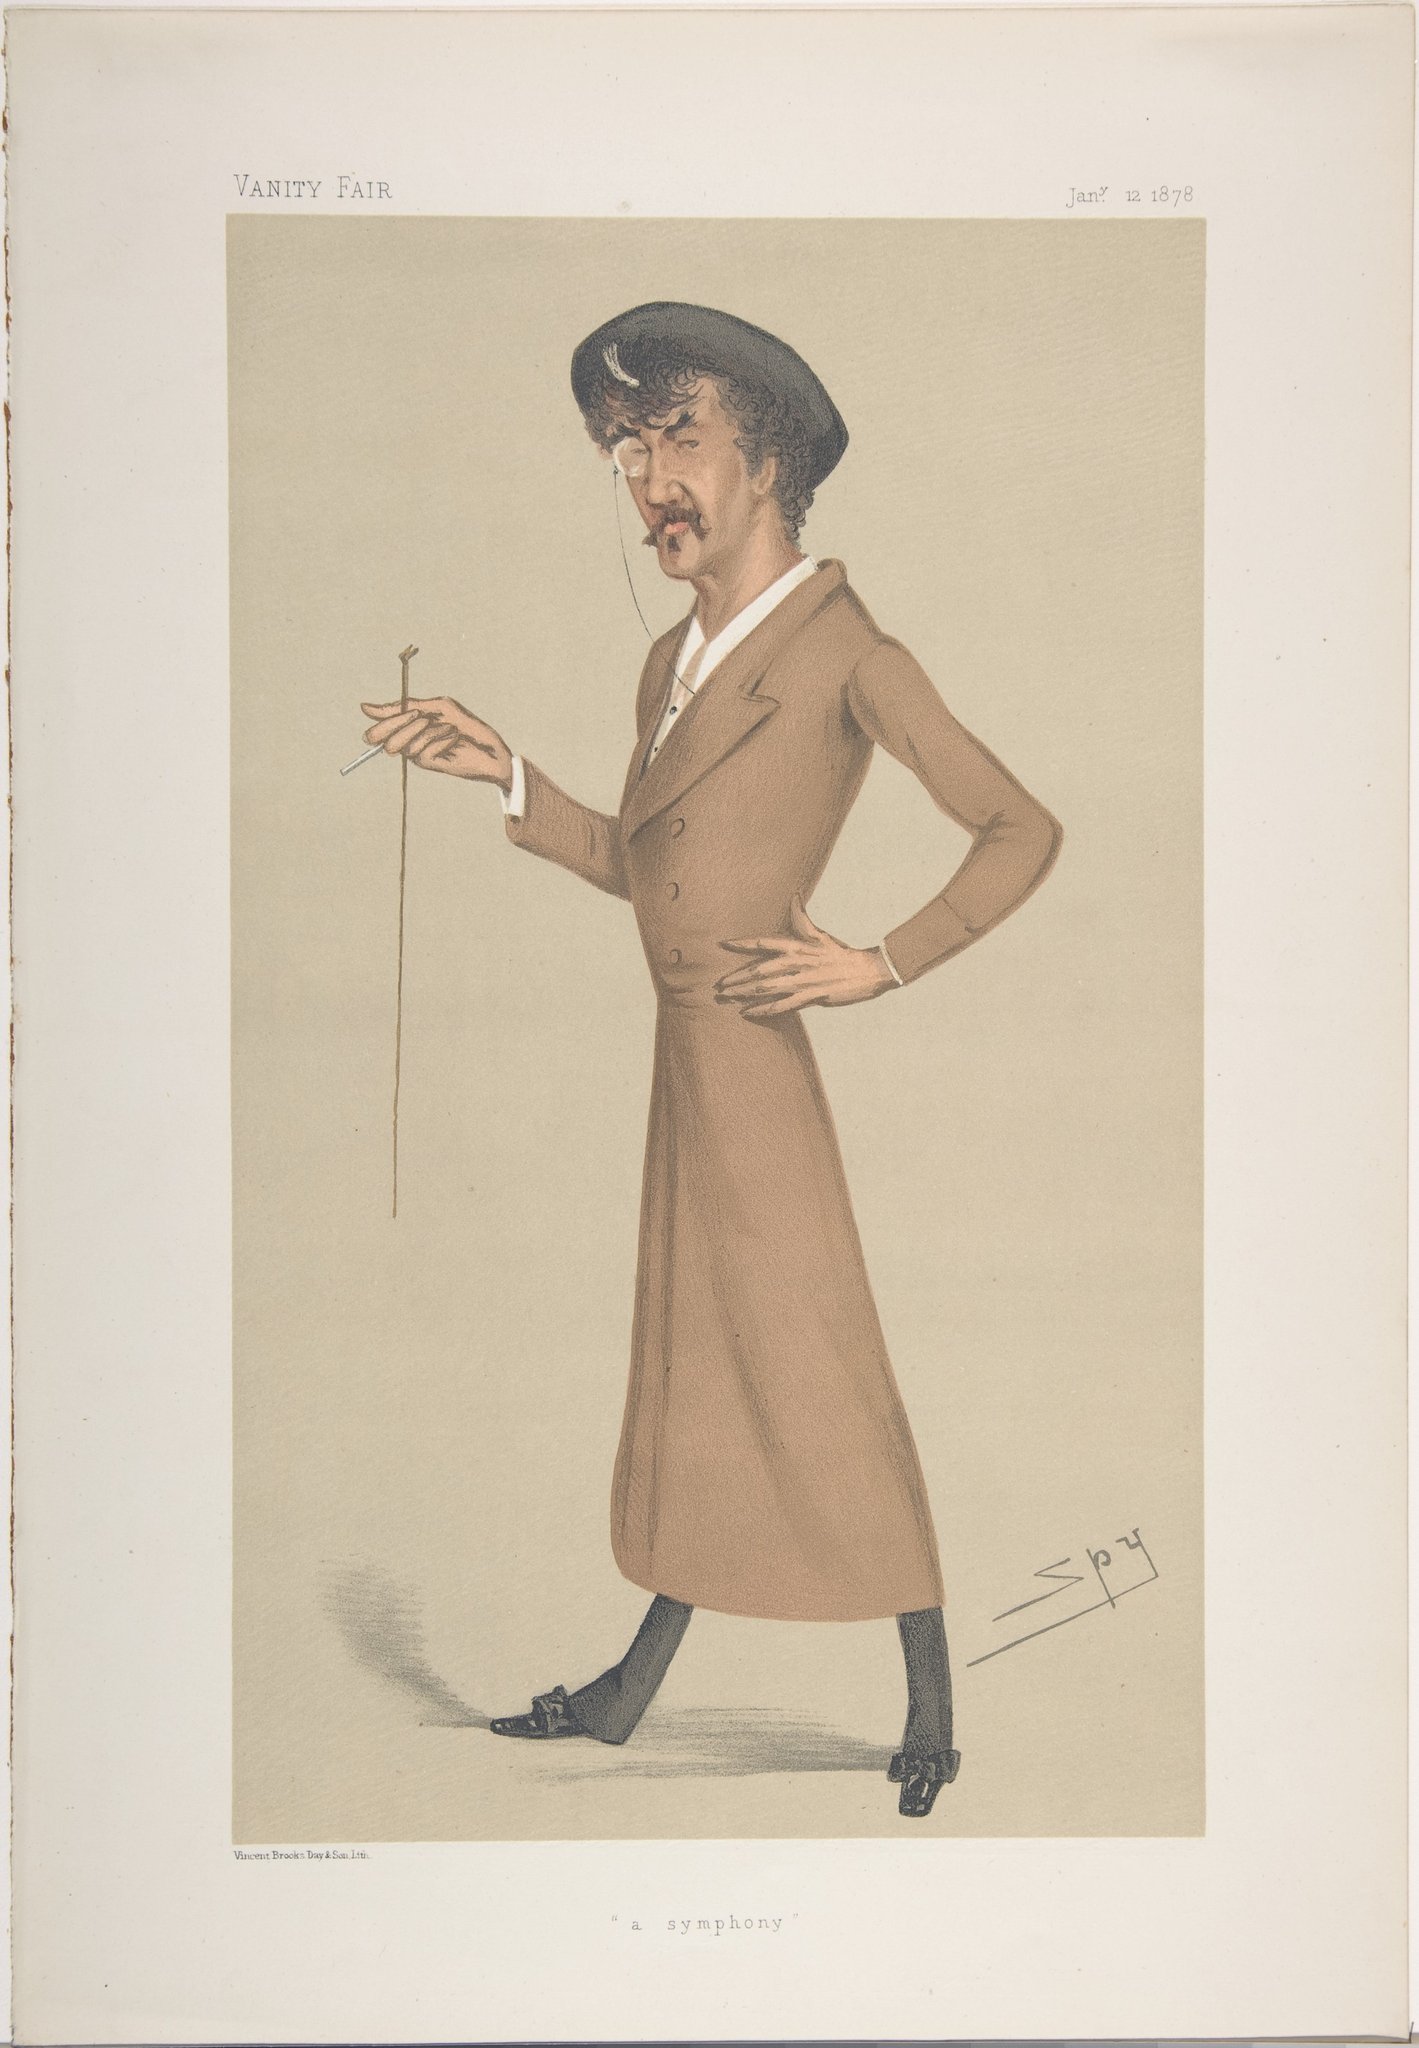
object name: print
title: A Symphony (from "Vanity Fair")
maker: sir leslie ward ["spy"]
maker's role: artist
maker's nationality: british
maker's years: 1851-1922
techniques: lithograph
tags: men